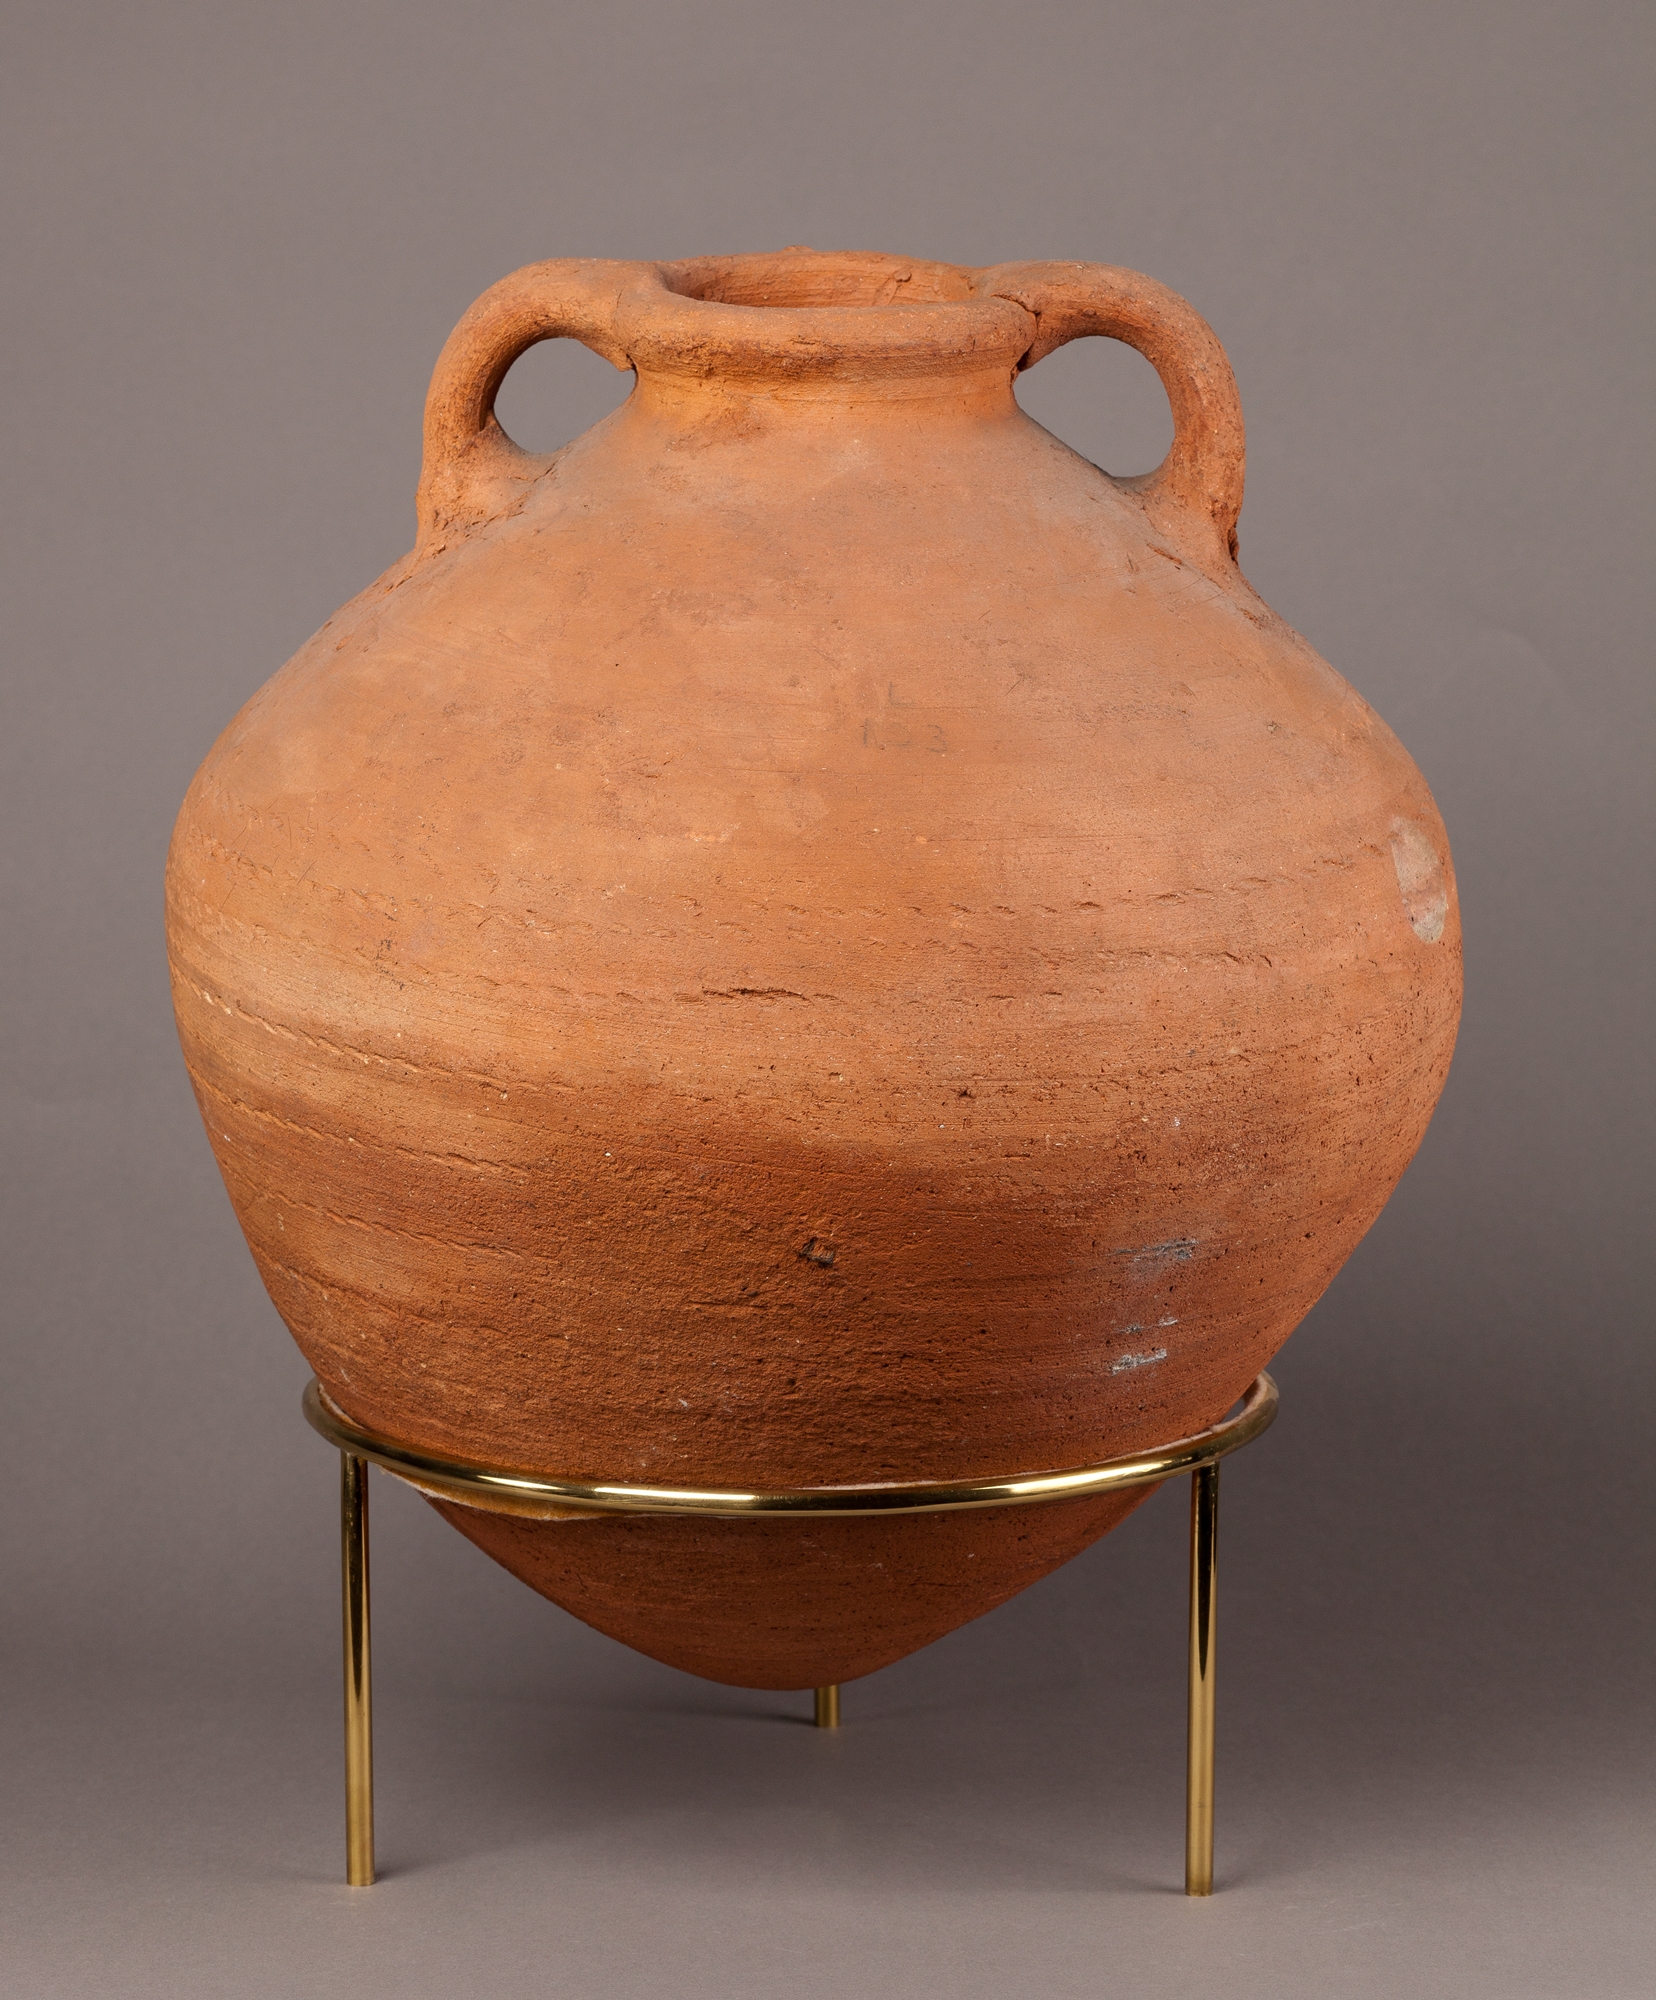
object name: jar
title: Round-Bottomed Jar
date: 1295-1070 BCE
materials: pottery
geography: egypt